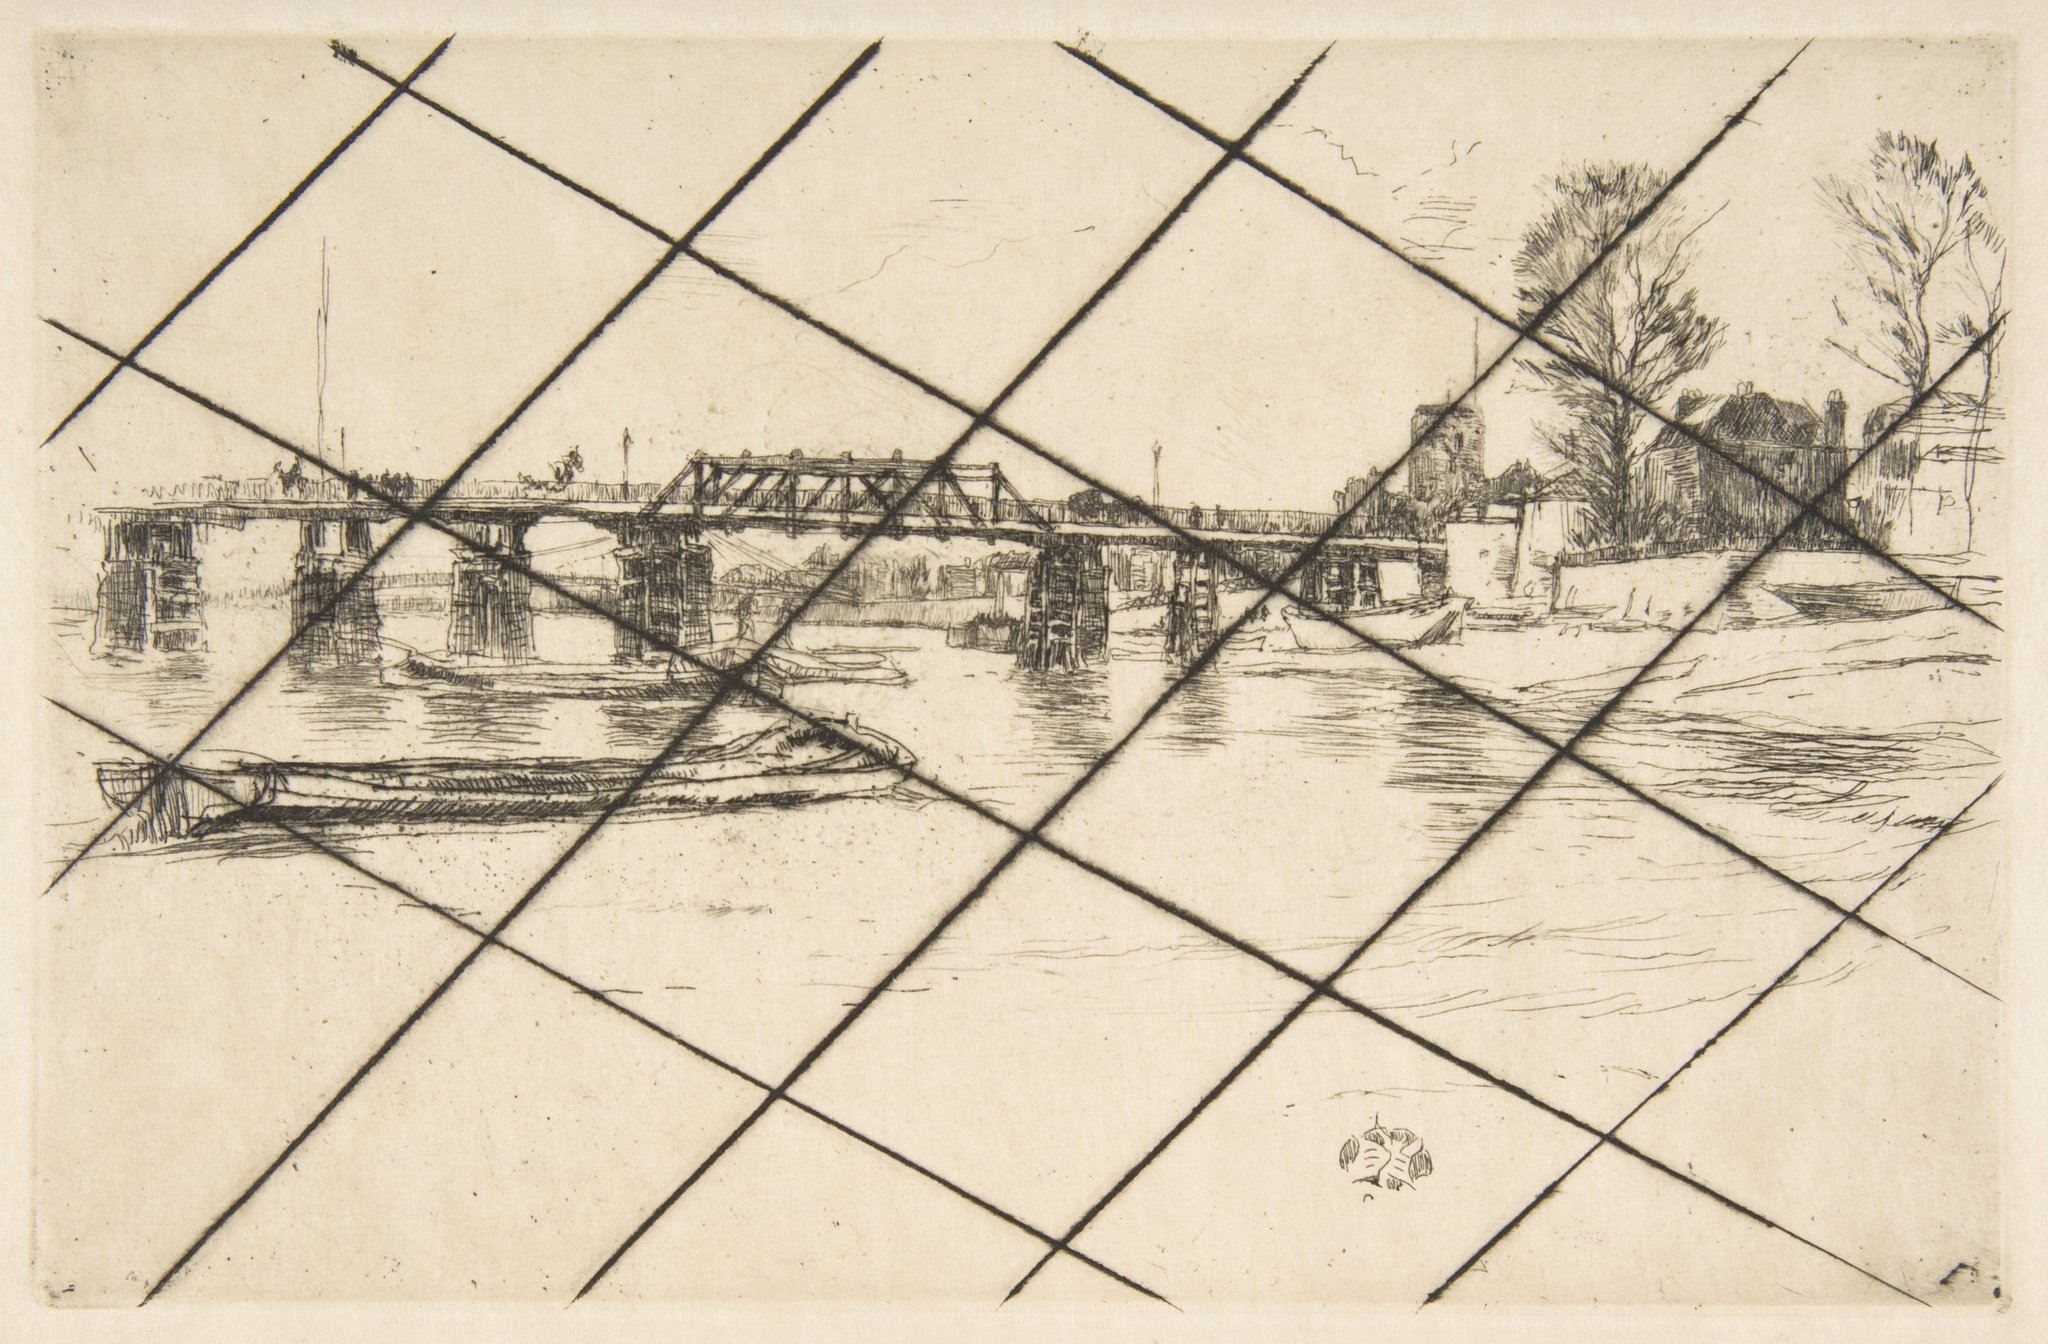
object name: print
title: Fulham (Chelsea)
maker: james mcneill whistler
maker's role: artist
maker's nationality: american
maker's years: 1834-1903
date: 1879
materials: ink, paper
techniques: drypoint, etching, printing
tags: bridges,rivers,boats